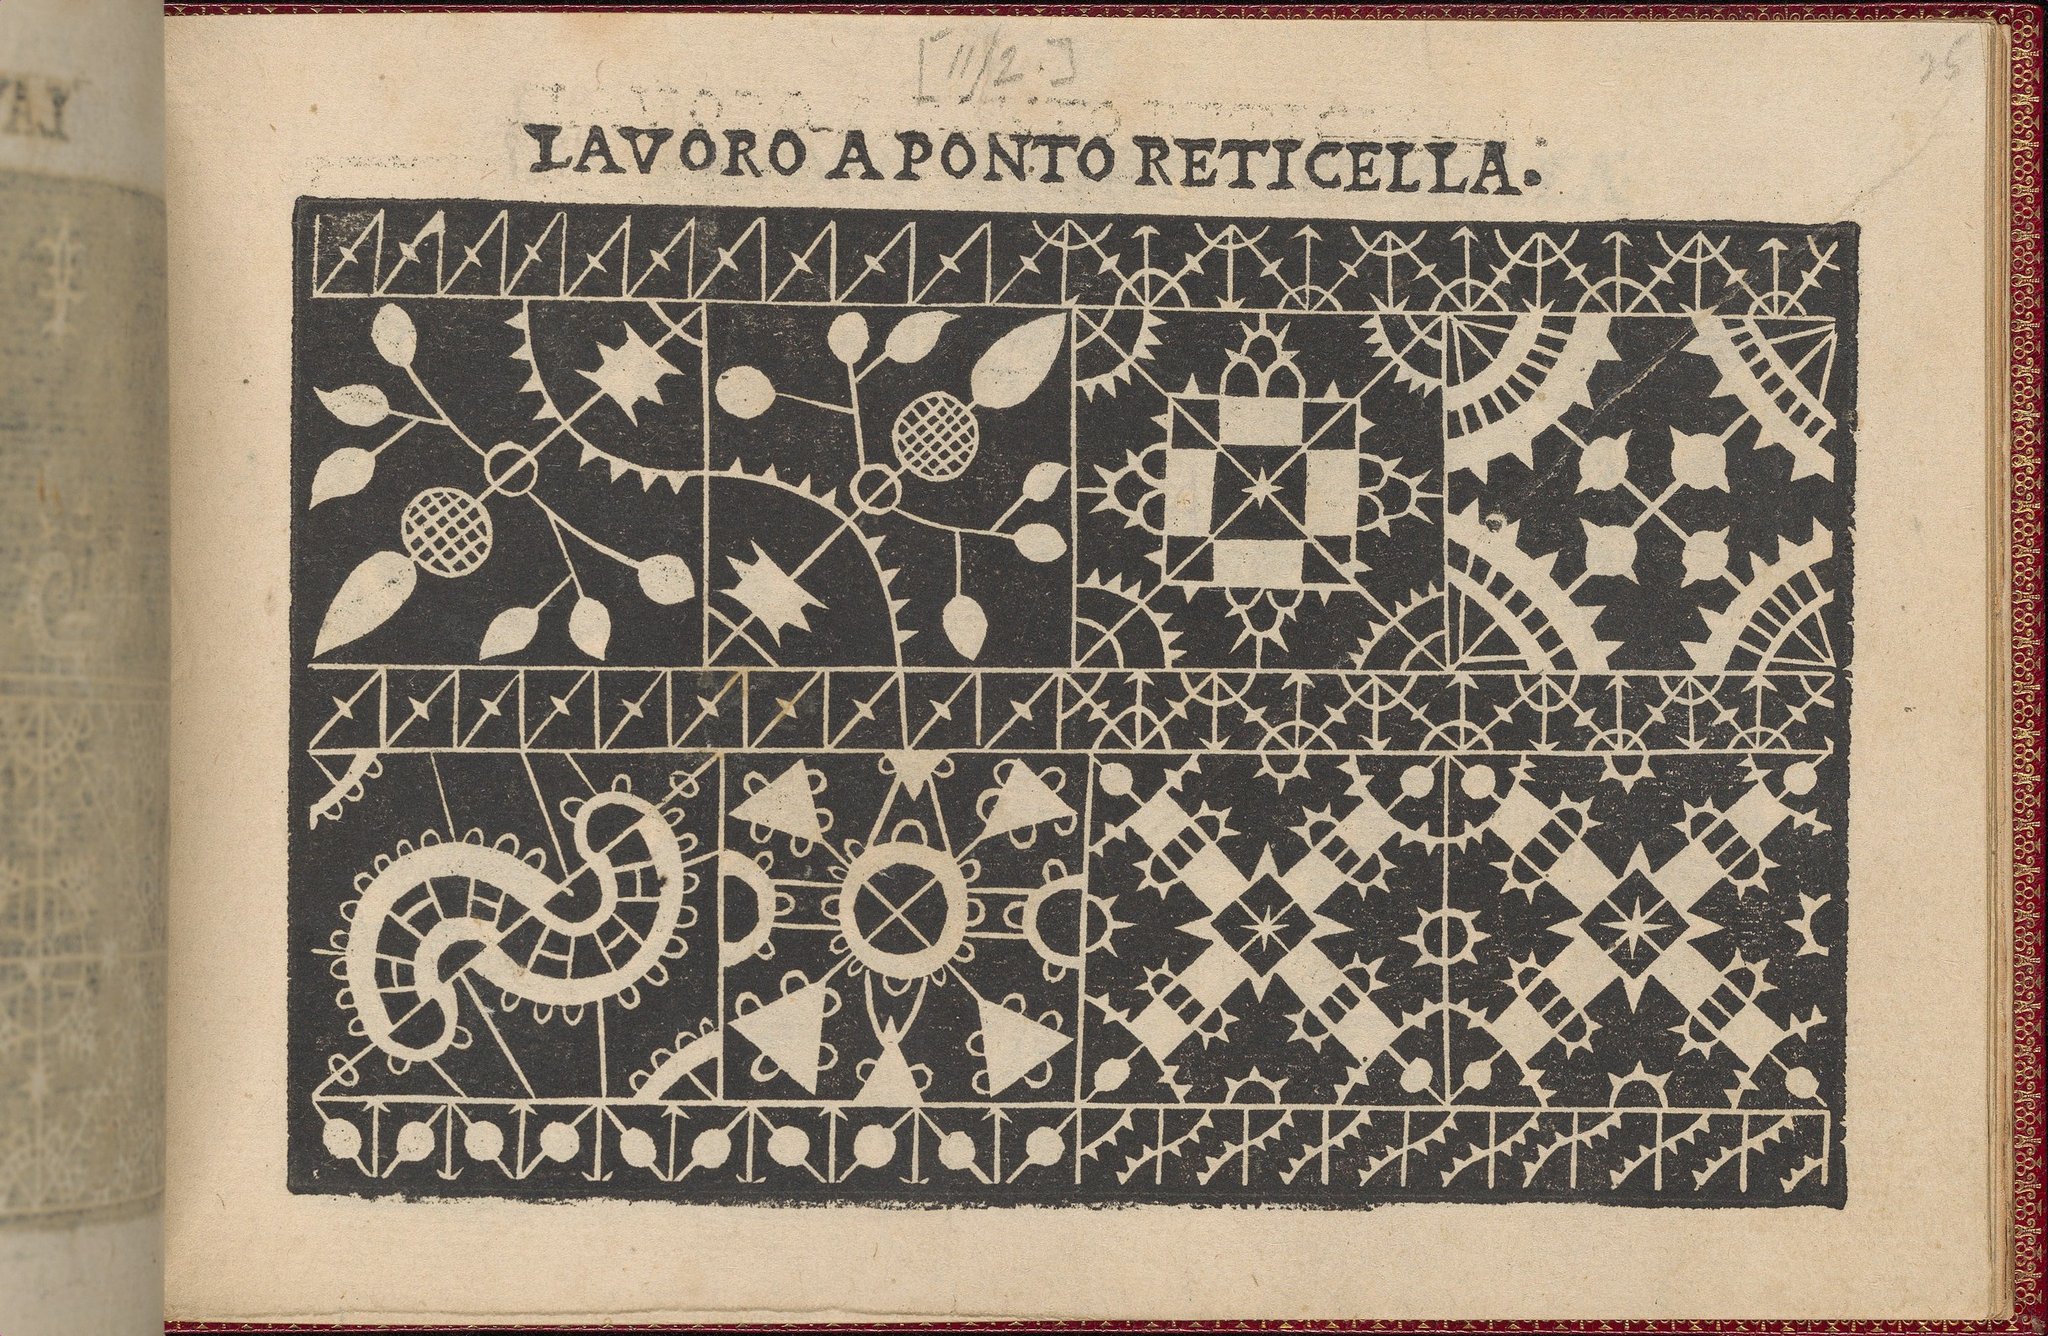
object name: book print ornament architecture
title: Pretiosa Gemma delle virtuose donne, page 27 (recto)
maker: isabella catanea parasole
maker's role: author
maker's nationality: italian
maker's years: 1565-1625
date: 1600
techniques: woodcut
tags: ornament